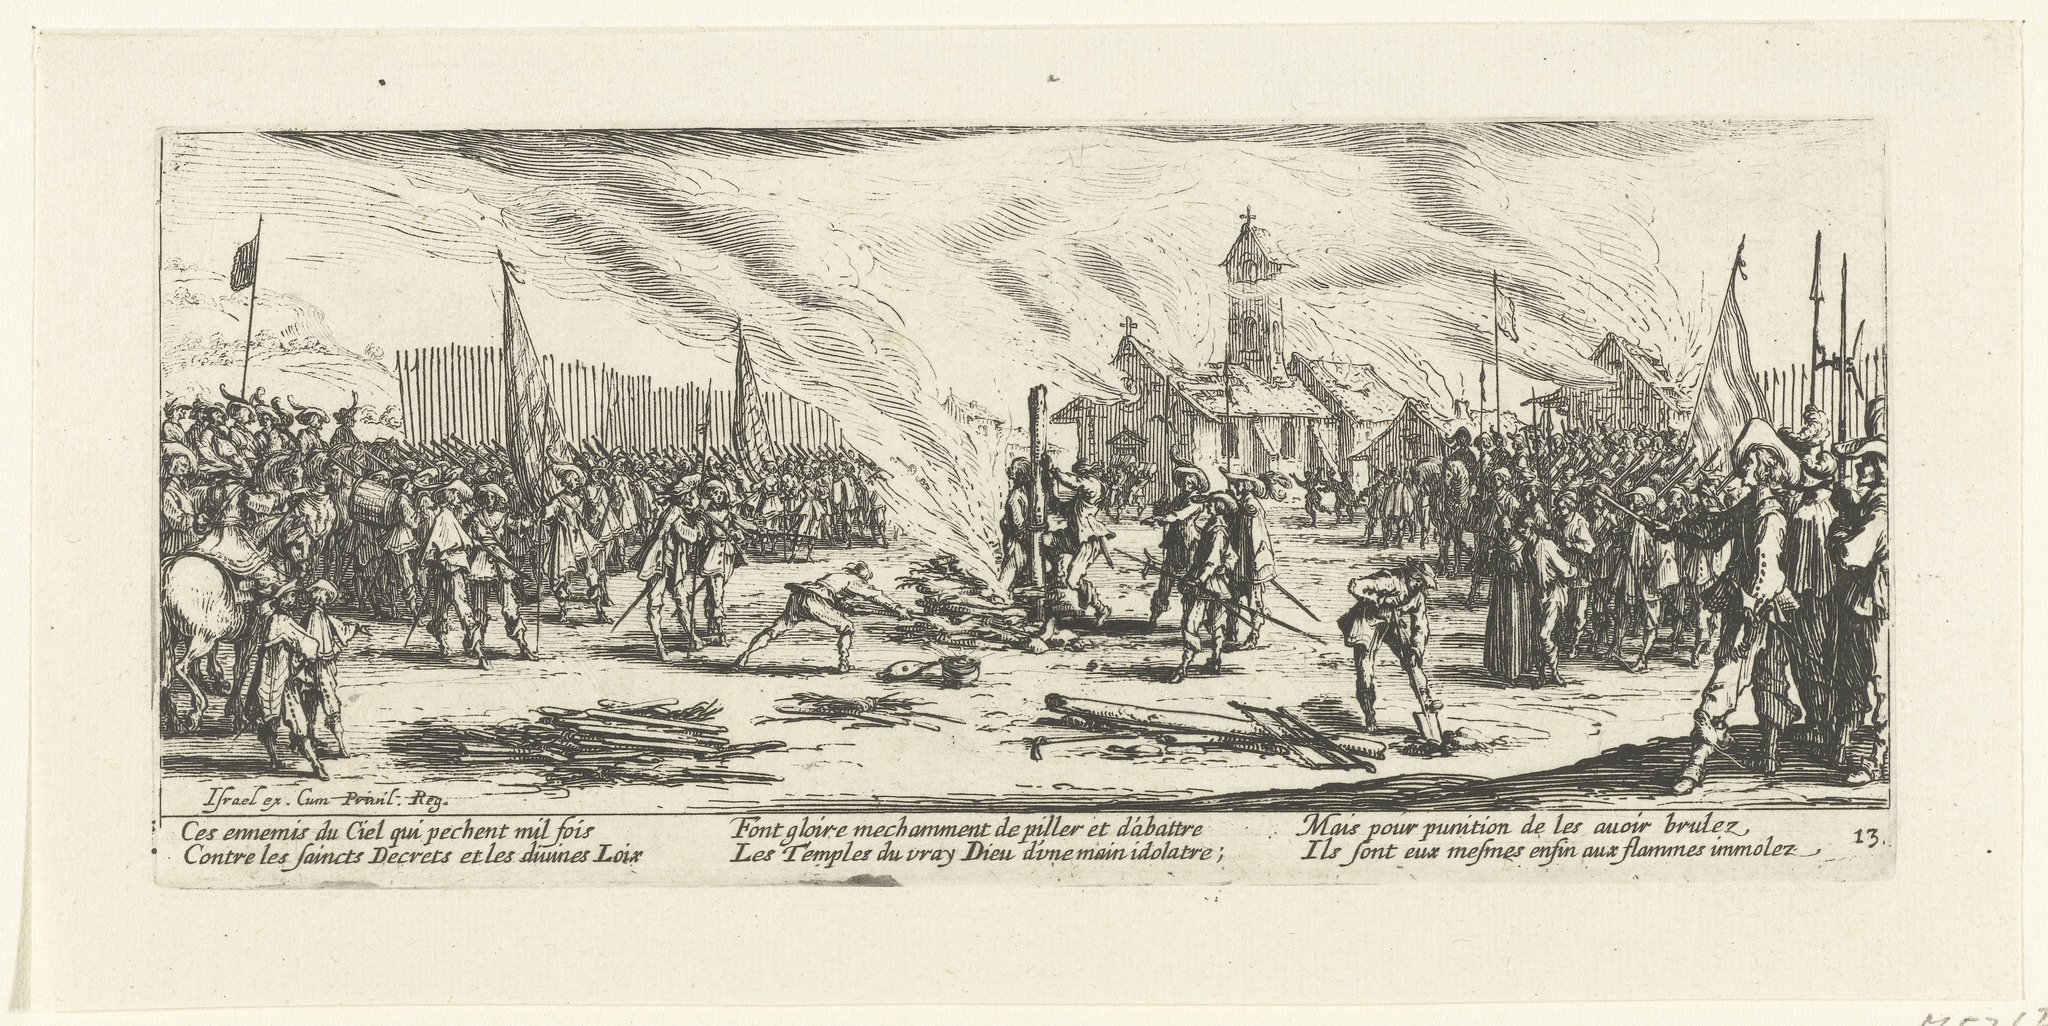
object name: print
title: Strafmaatregelen: de brandstapel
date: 1633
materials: paper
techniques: etching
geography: paris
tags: church (exterior), violent death by burning at the stake; pyre, execution ~ military disciplinary punishment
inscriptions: collector's mark: Lugt 240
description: Op een open plek bij een kerk en enkele huizen die in brand staan, kijken vele soldaten toe hoe een man, aan een paal gebonden, op een brandstapel sterft. Onder de voorstelling een zesregelig Frans vers. Deze prent is onderdeel van een serie van 17 (18 incl. titelprent) prenten met voorstellingen van diverse soorten ellende die oorlogvoering met zich meebrengt.